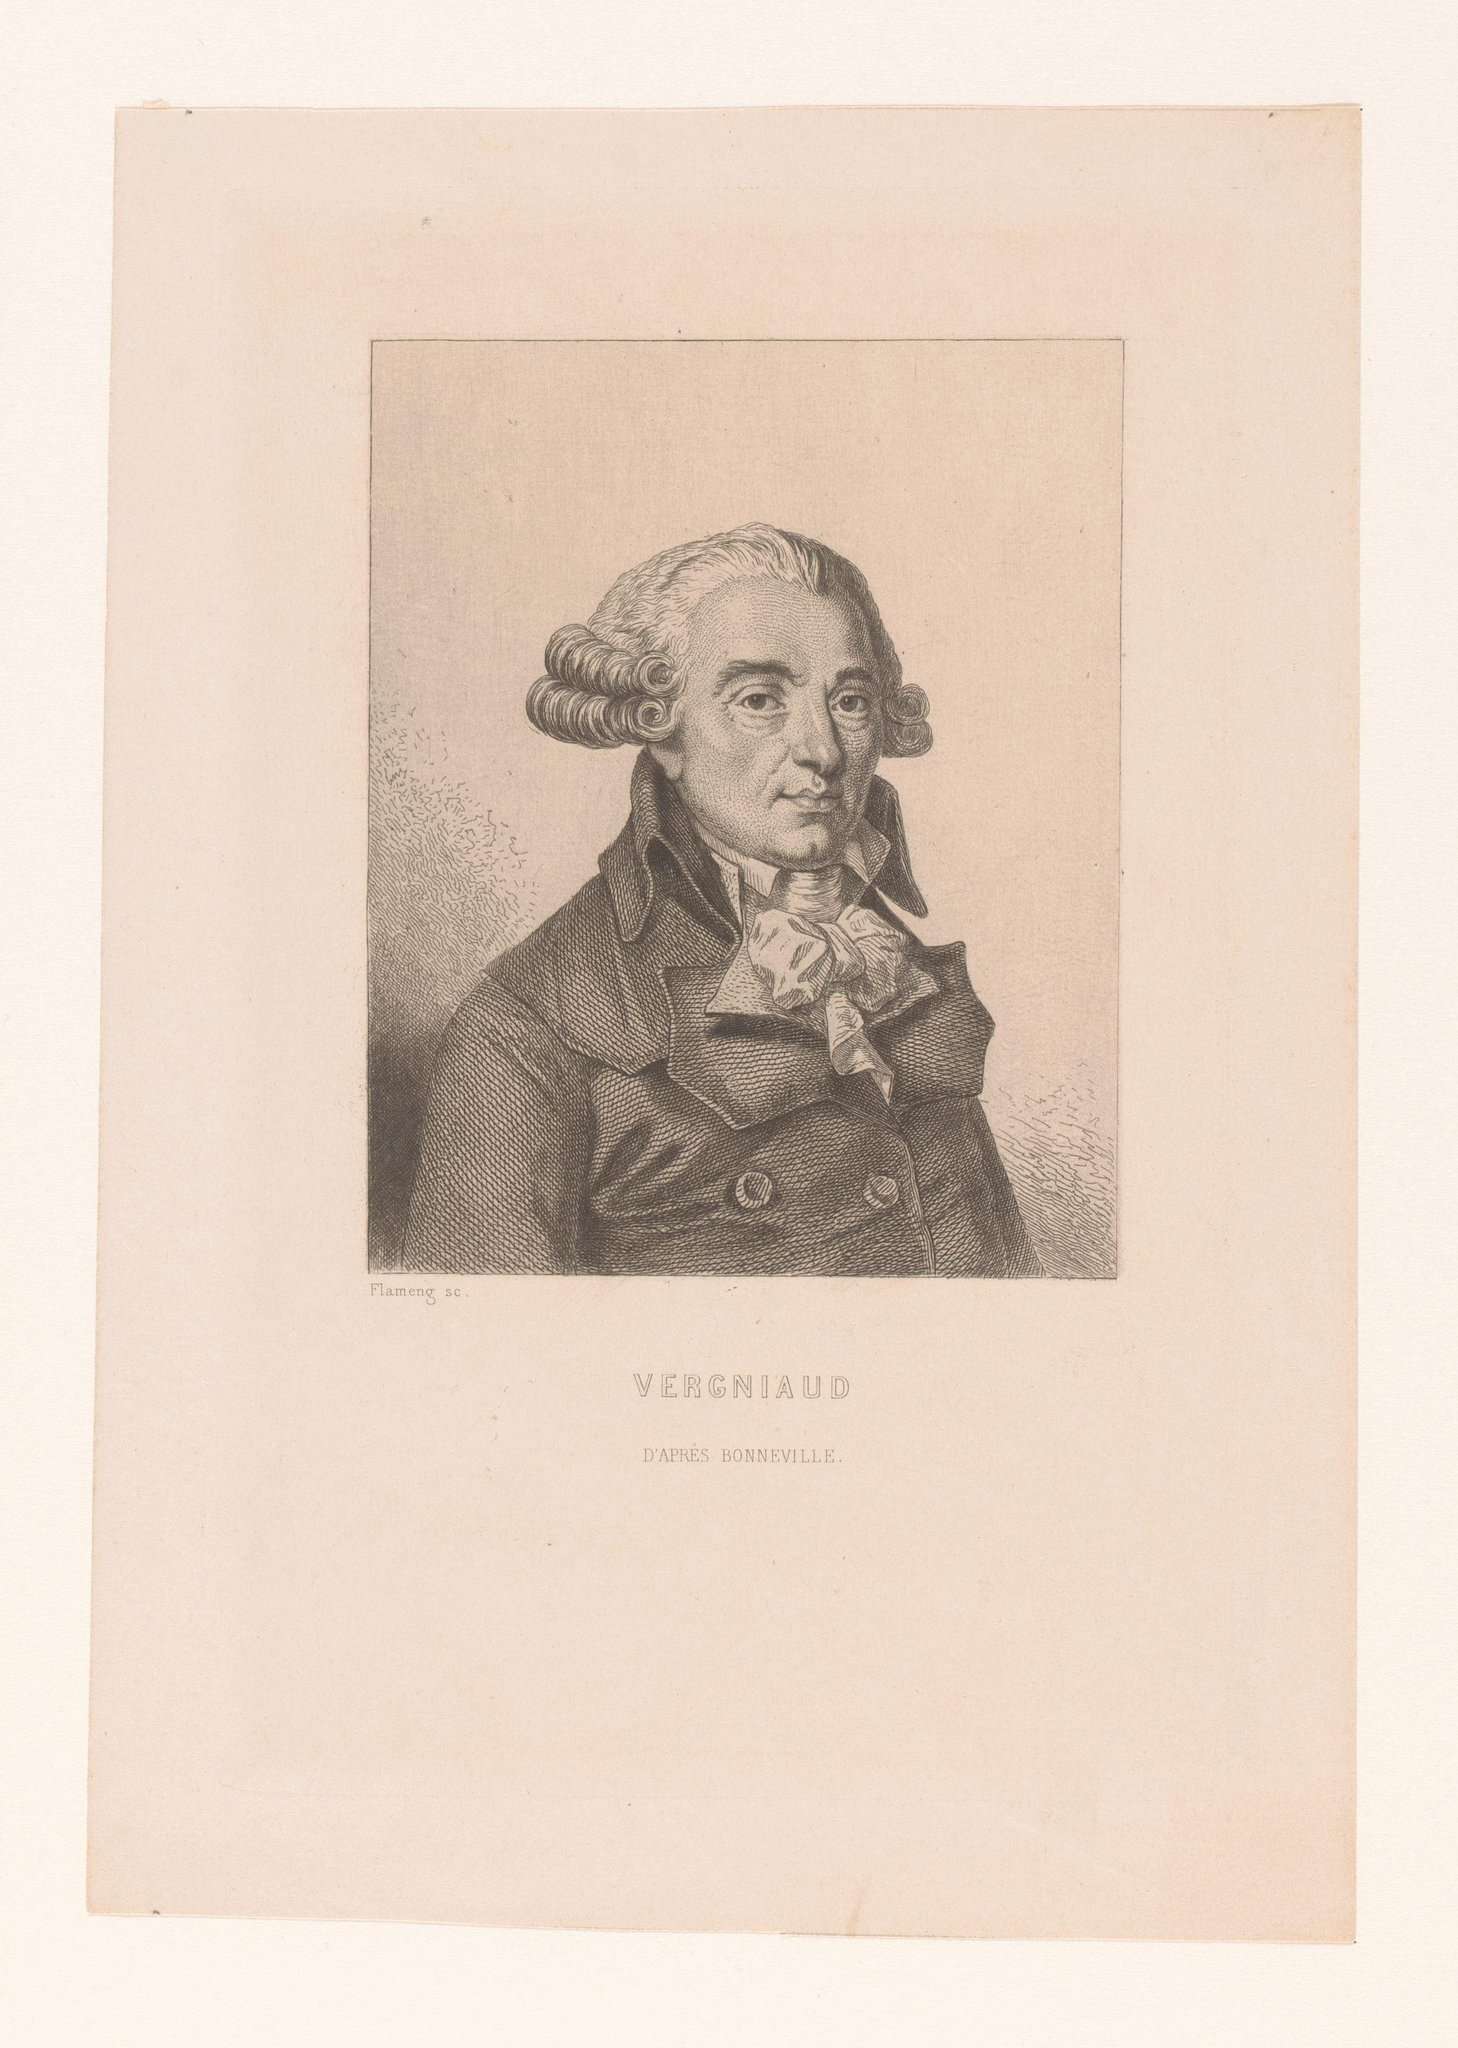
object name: print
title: Portret van Pierre Victurnien Vergniaud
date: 1841-1910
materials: paper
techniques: etching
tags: politician, historical persons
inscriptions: collector's mark: Lugt 2228